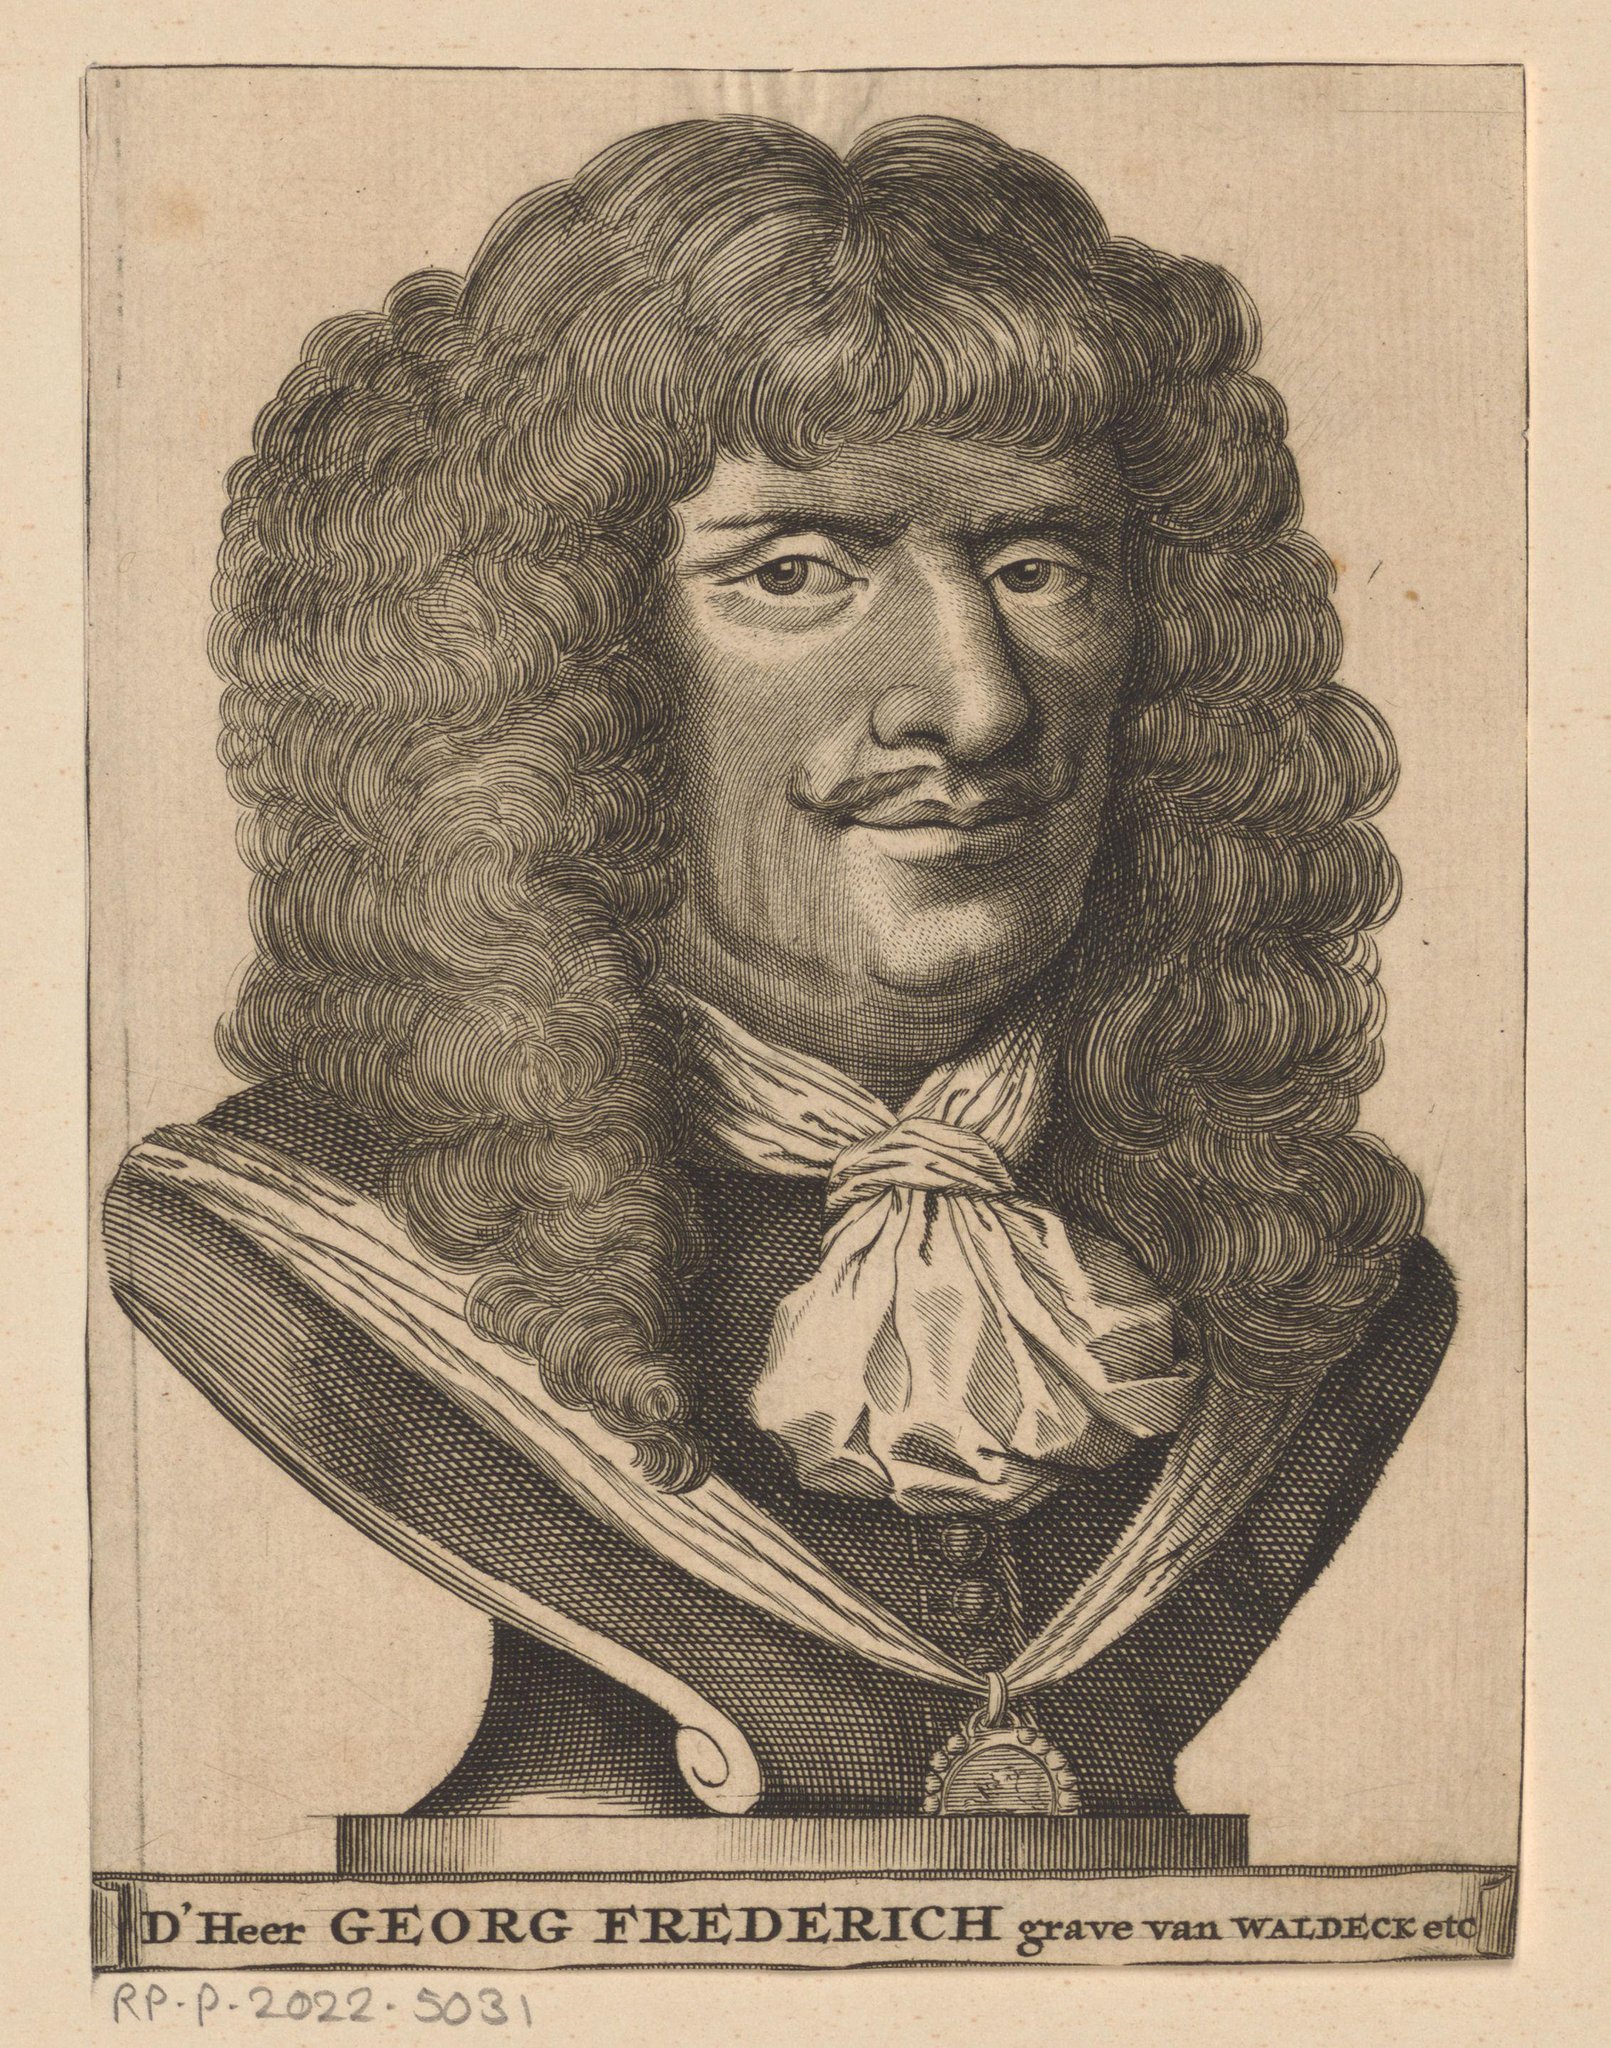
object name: print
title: Portret van Georg Friedrich prins van Waldeck-Eisenberg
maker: Anonymous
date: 1674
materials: paper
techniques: engraving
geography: northern netherlands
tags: commander-in-chief, general, marshal, prince, historical persons, medals and other marks of military honour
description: Prent waarschijnlijk uit: Domselaer, Tobias van. Het ontroerde Nederlandt, Door wapenen des Konings van Vrankrijk (...). Amsterdam: Markus Willemsz. Doornik, 1674.